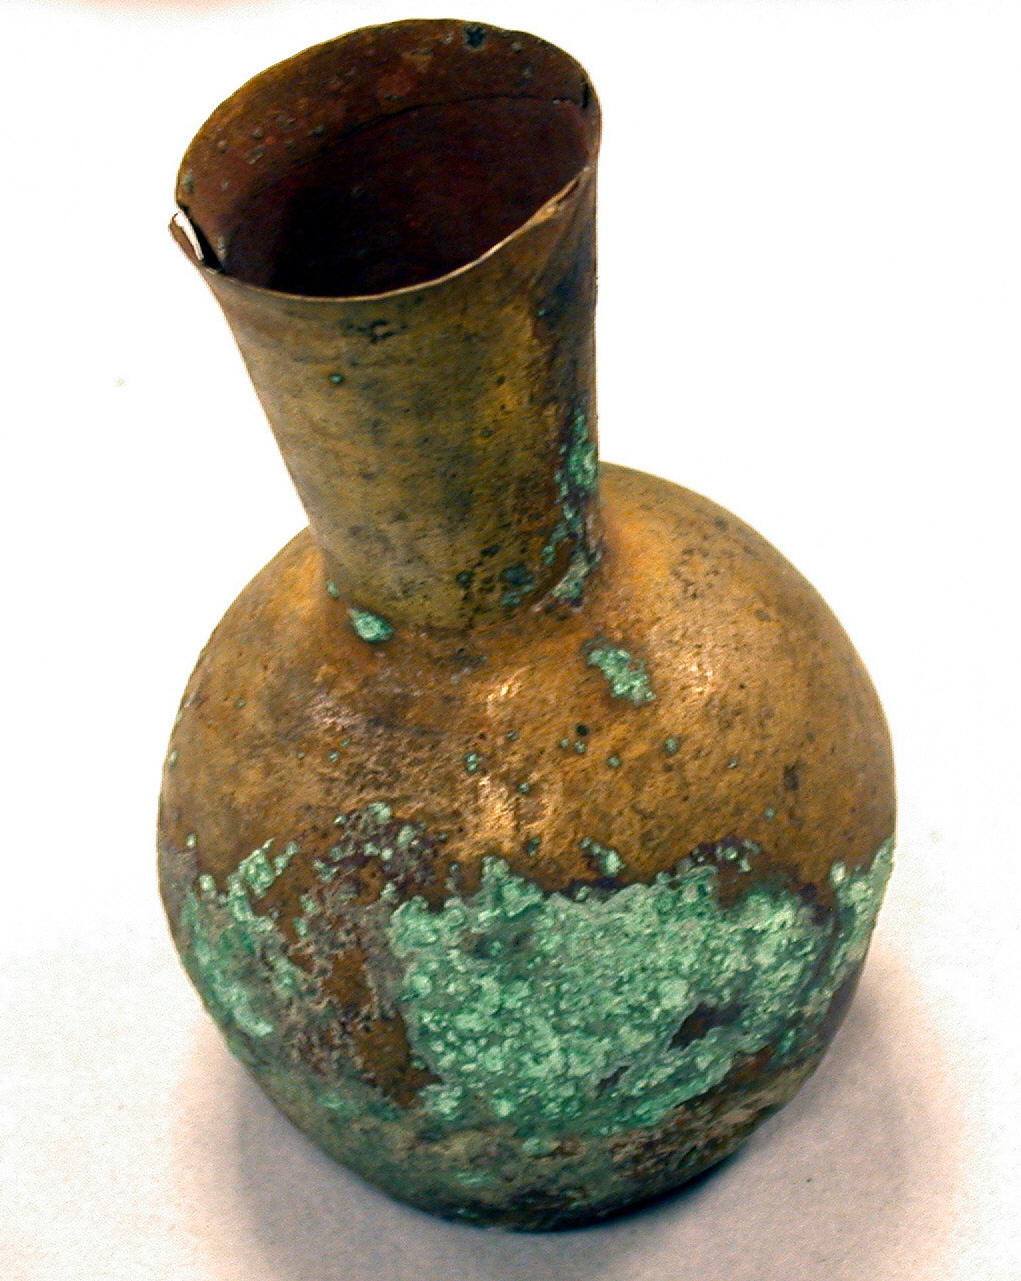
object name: bottle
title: Miniature Bottle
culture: chancay or chimú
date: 1001-1500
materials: gilt, silver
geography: peru